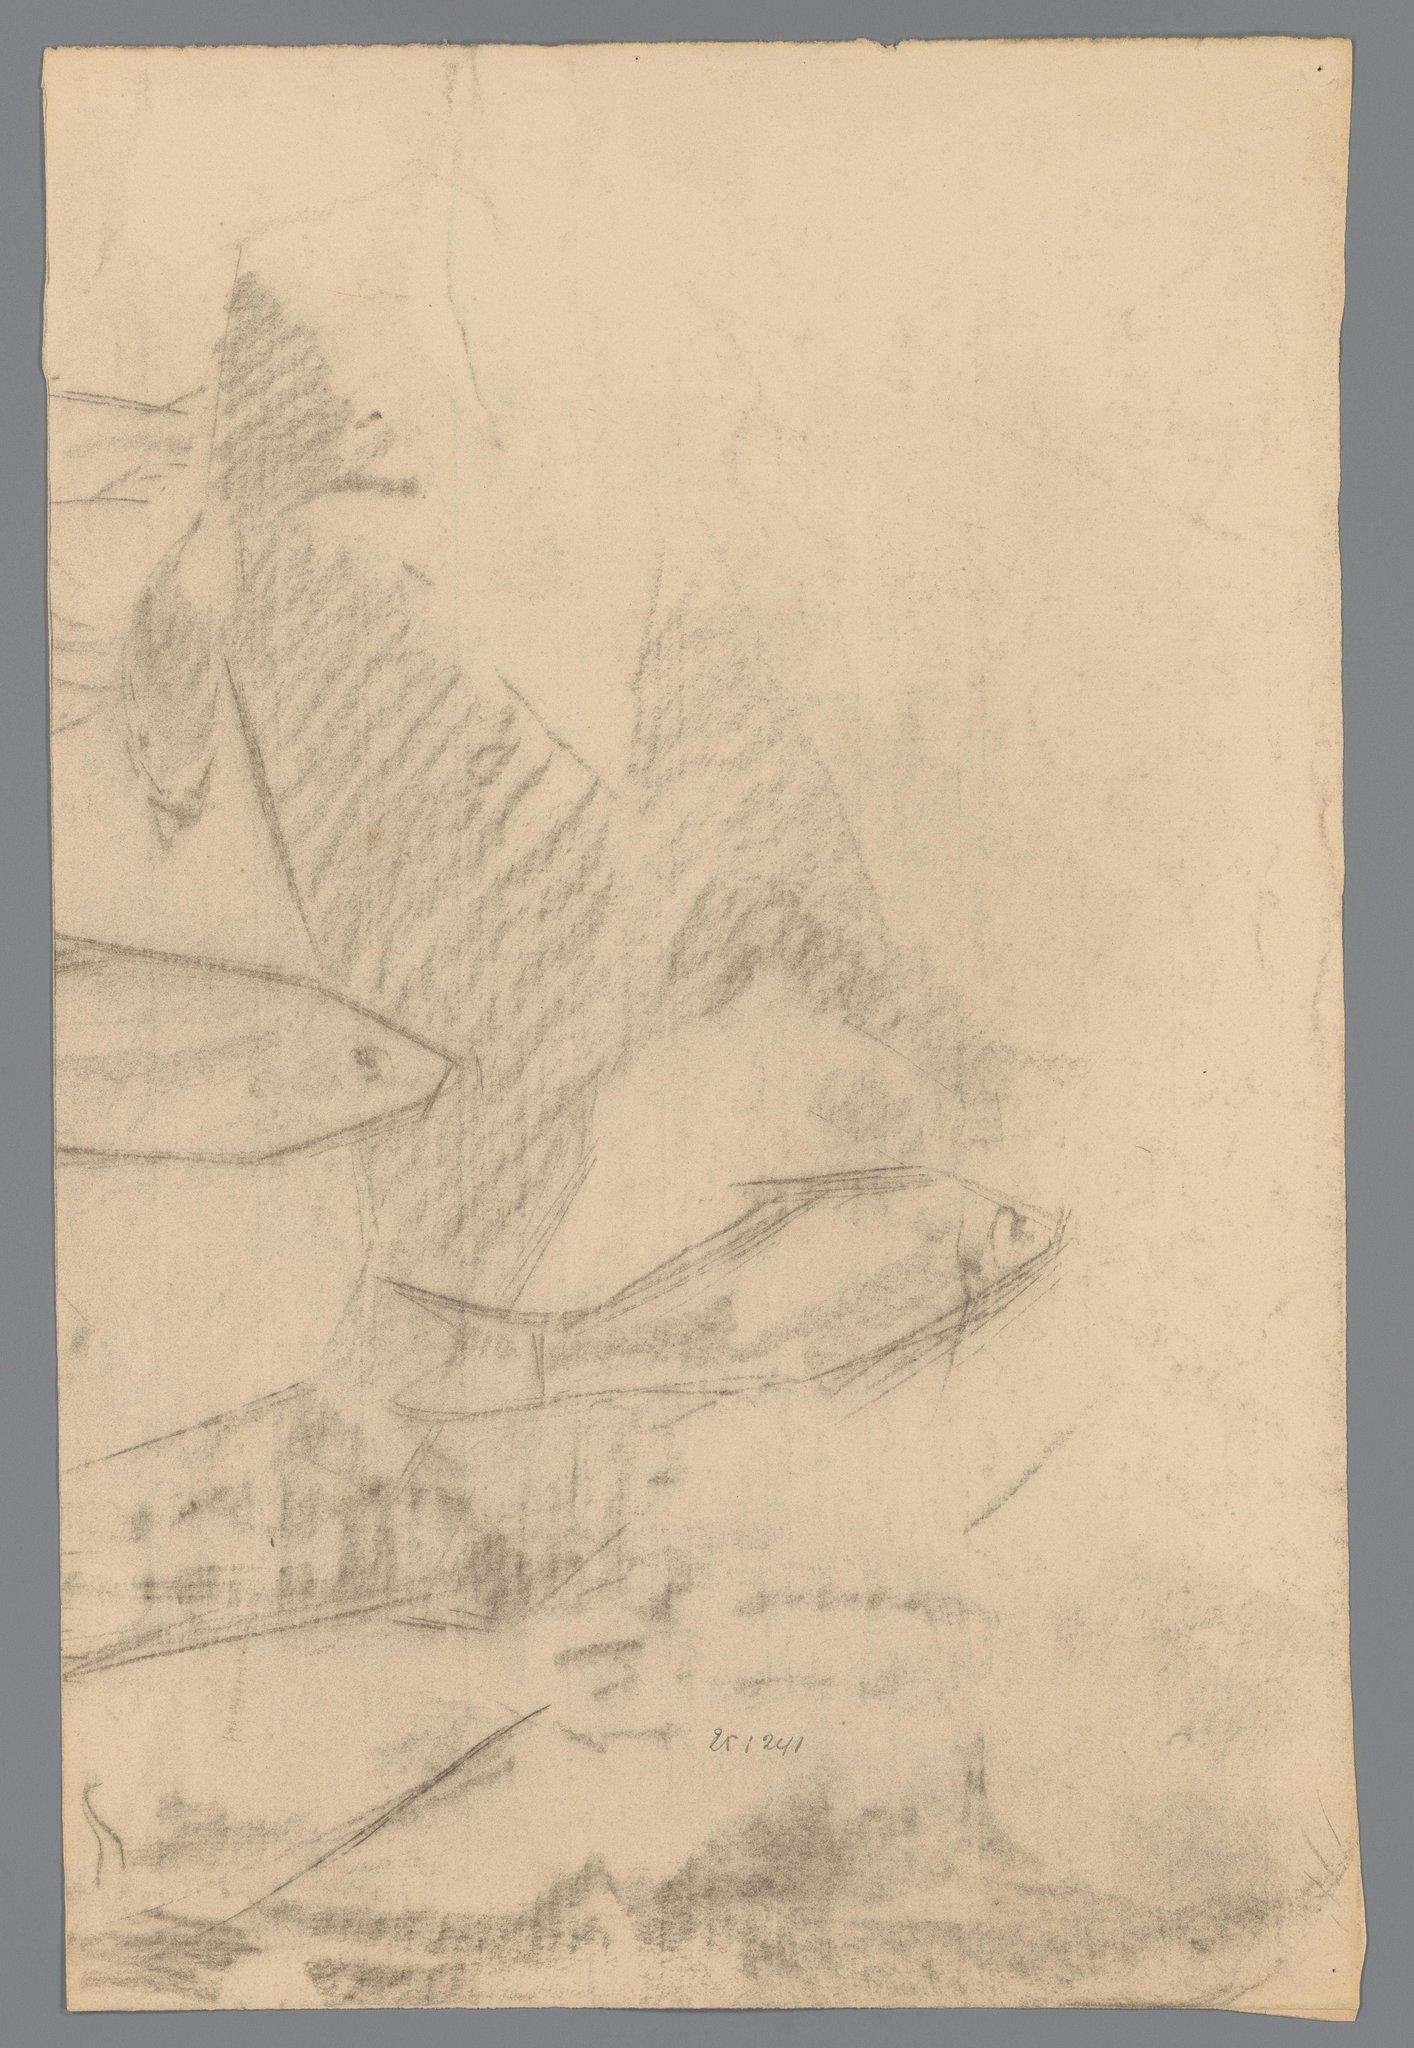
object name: drawing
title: Schets van vissen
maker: gerrit willem dijsselhof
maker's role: designer, draughtsman, print maker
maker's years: 1866-1924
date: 1876-1924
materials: chalk, paper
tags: fishes